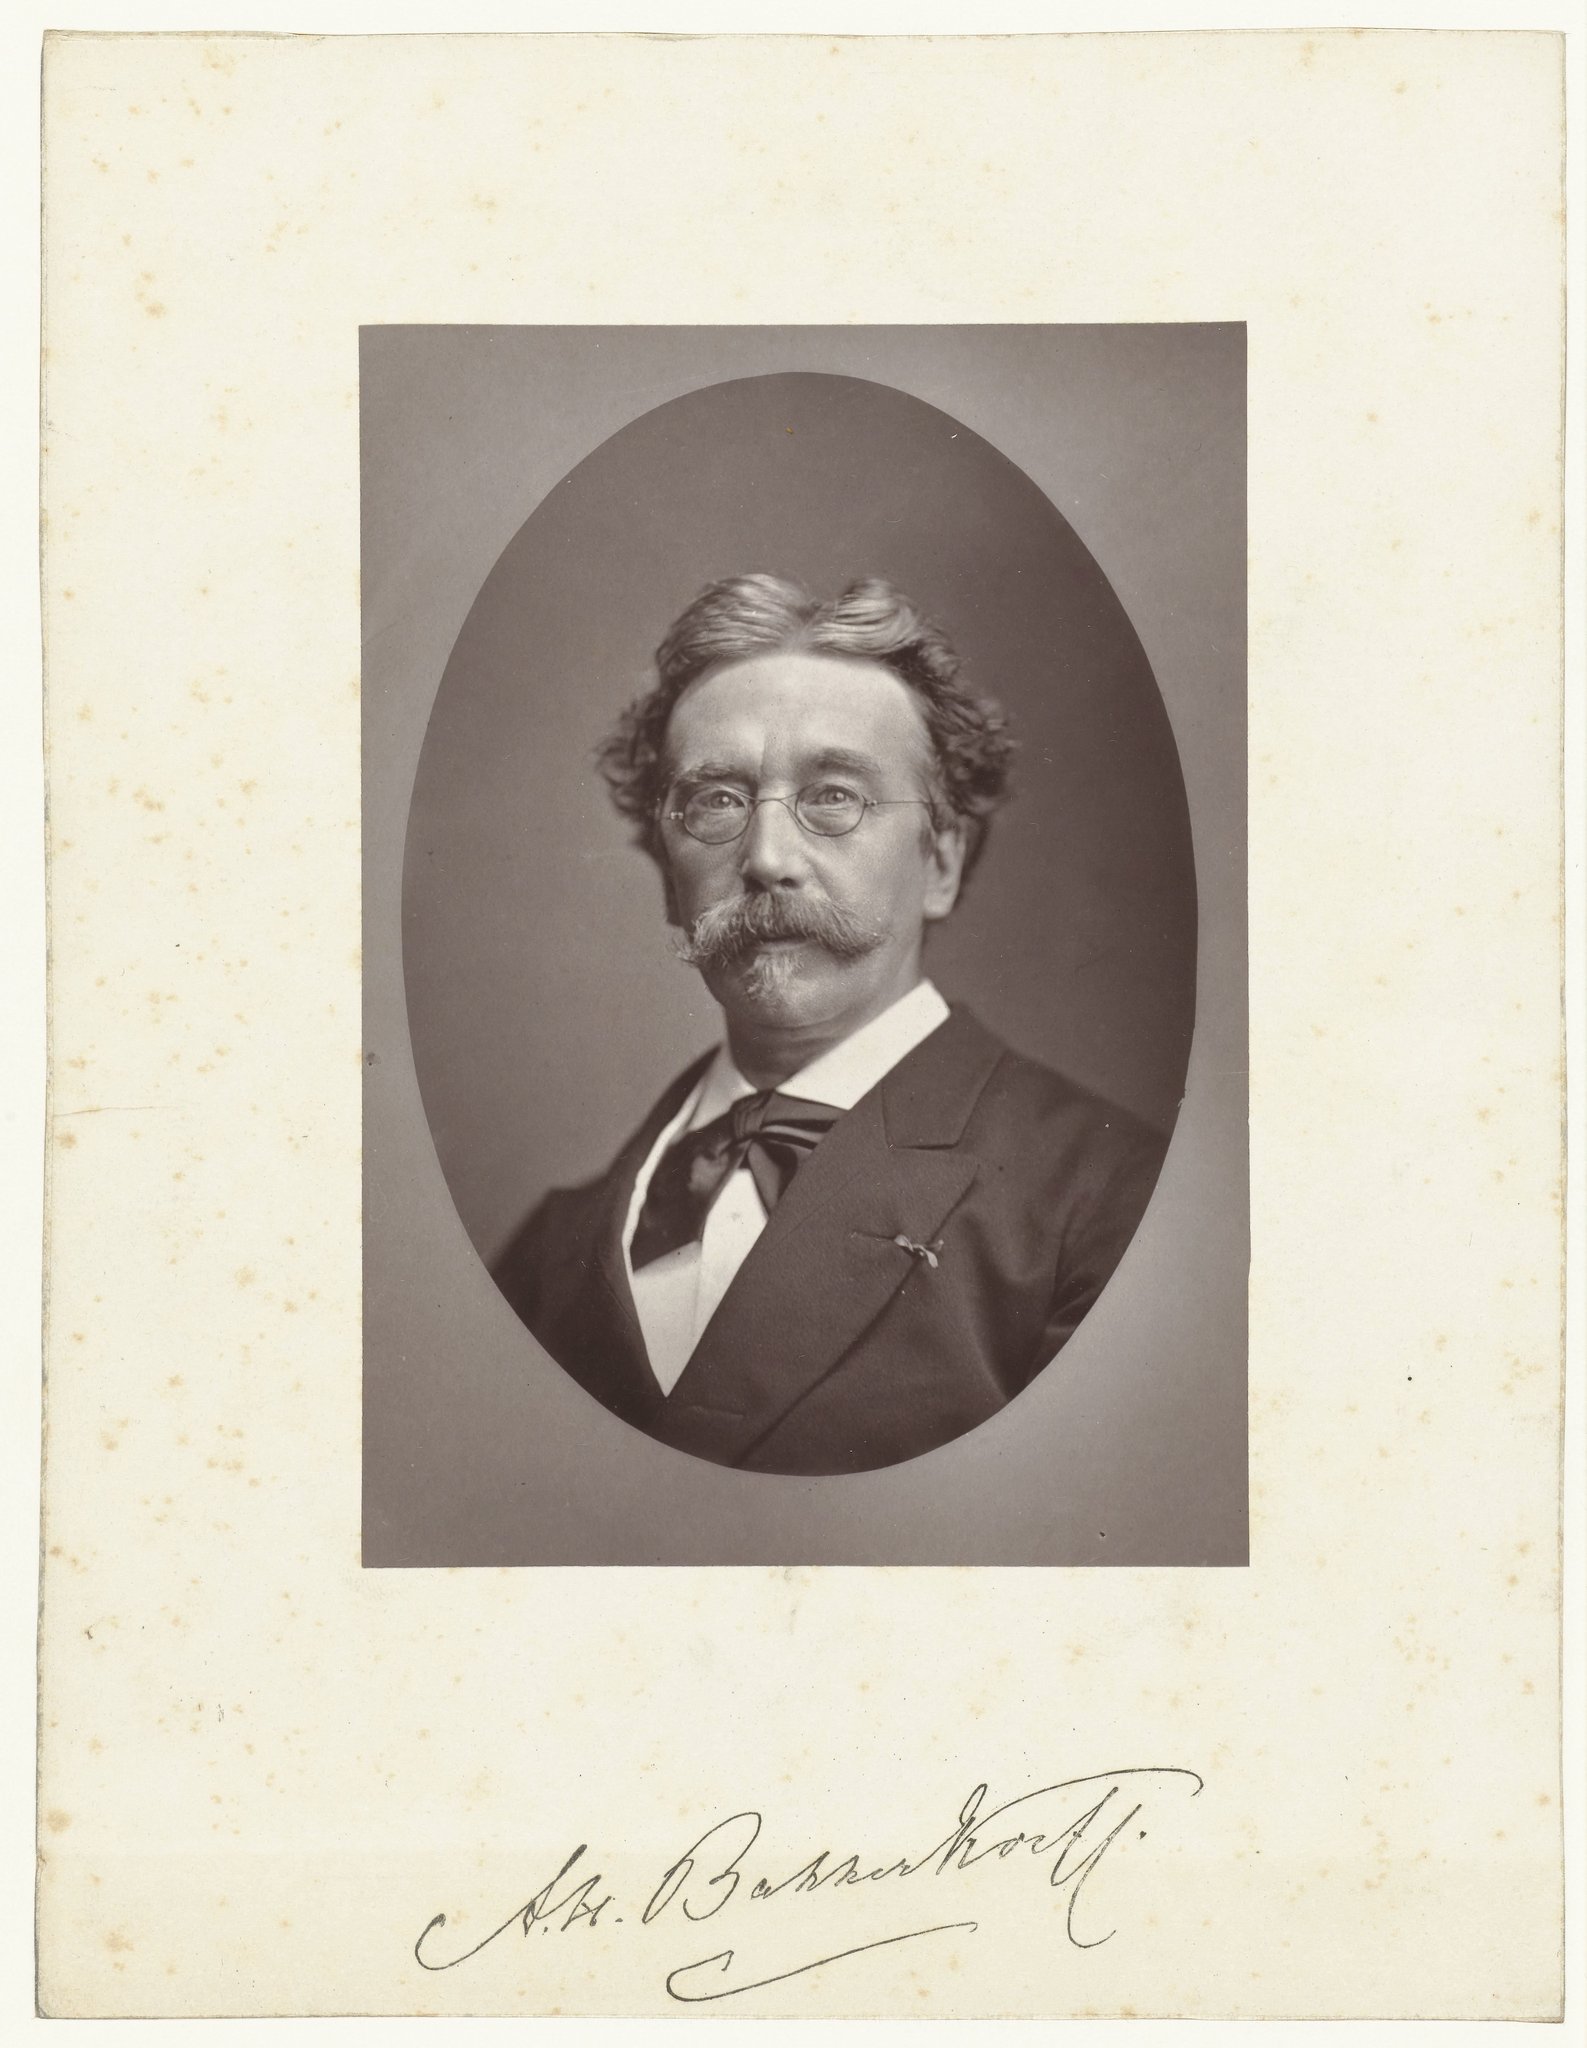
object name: photograph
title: Portret van A.H. Bakker Korff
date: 1881-1885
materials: cardboard, paper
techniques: woodburytype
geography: the hague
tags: the hague, leiden, draughtsman, alexander hugo bakker korff, historical persons